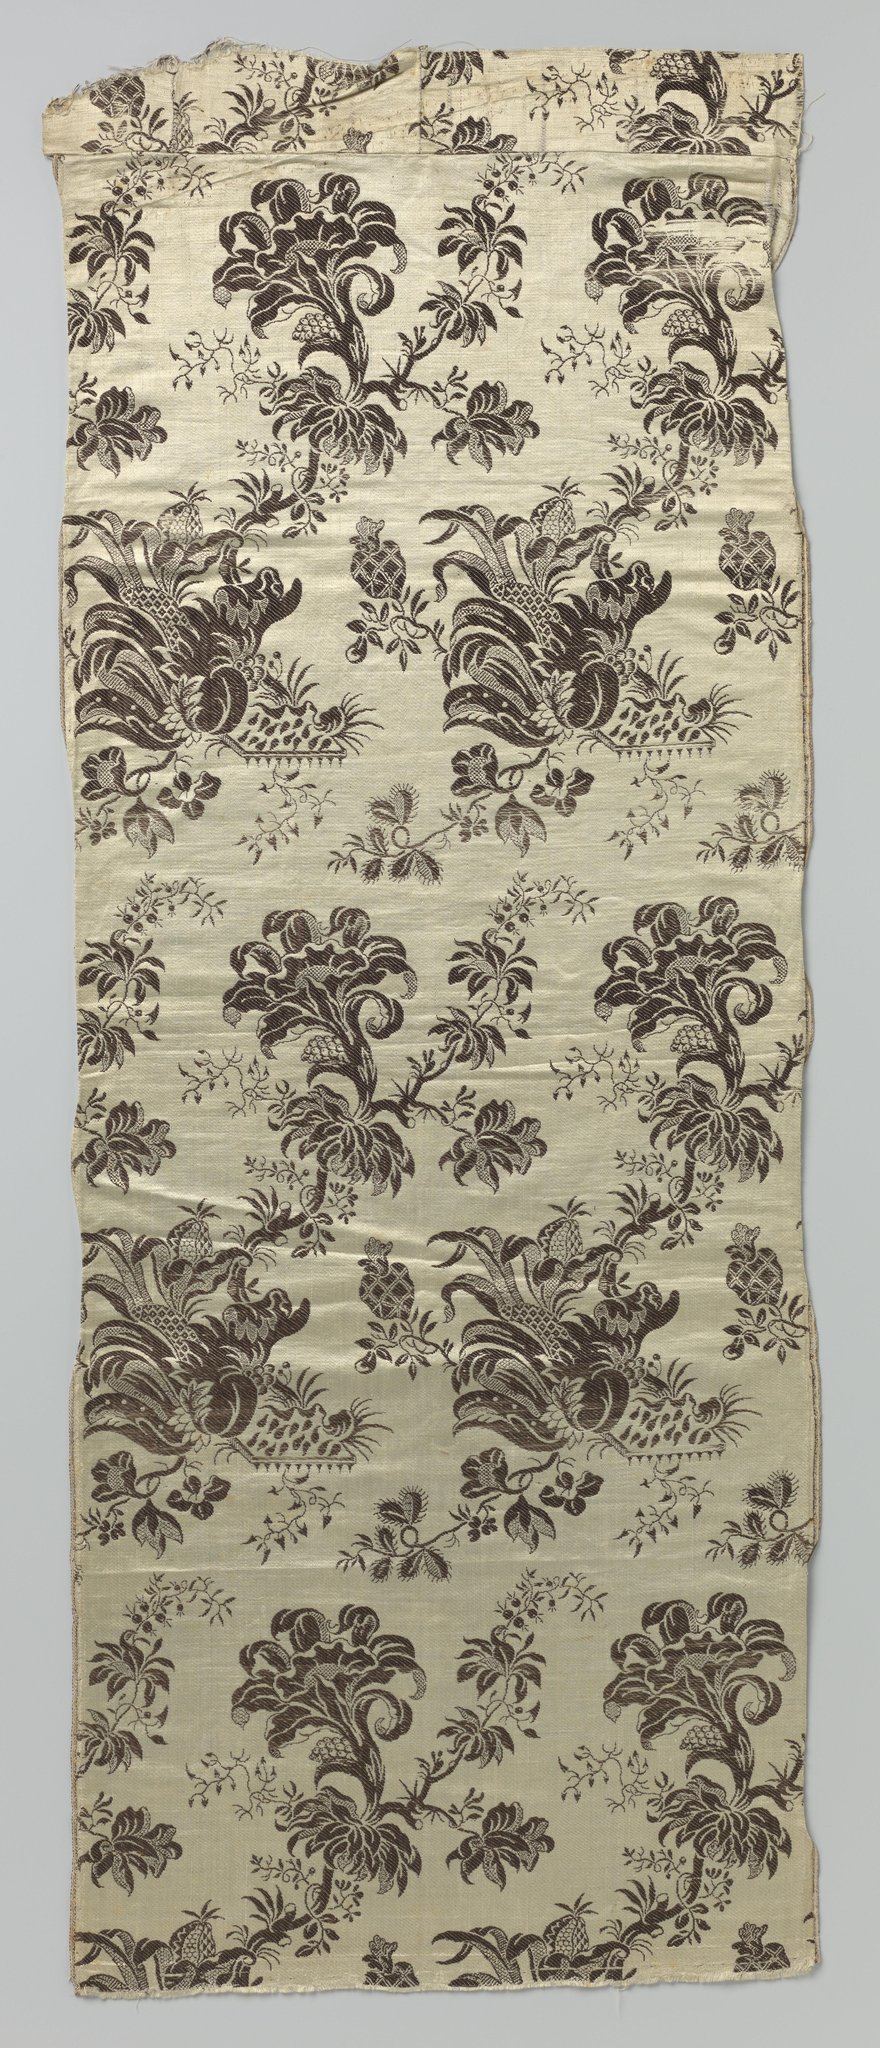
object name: silk textile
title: Fragment van twee aan elkaar genaaide banen zijdedamast met o.a. horizontale rijen met grote bloemen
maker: Anonymous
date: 1880-1920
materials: silk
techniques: lampas, weave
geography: france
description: Fragment van twee aan elkaar genaaide banen gelanceerde zijdedamast met een dessin van horizontale rijen grootschalige bloemen met omhoogrijzende tak waaraan bloemen en bladeren, gelegen op een tafelblad afgezet met een gepunte rand in bruin op cremekleurig fond. Navolging Franse weefsels uit ca. 1730.